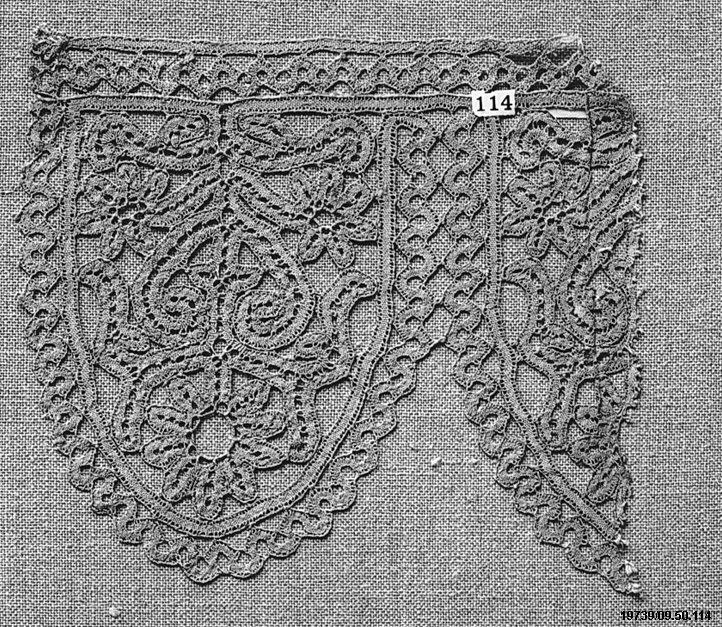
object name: fragment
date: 1701-1800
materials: silk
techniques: lace